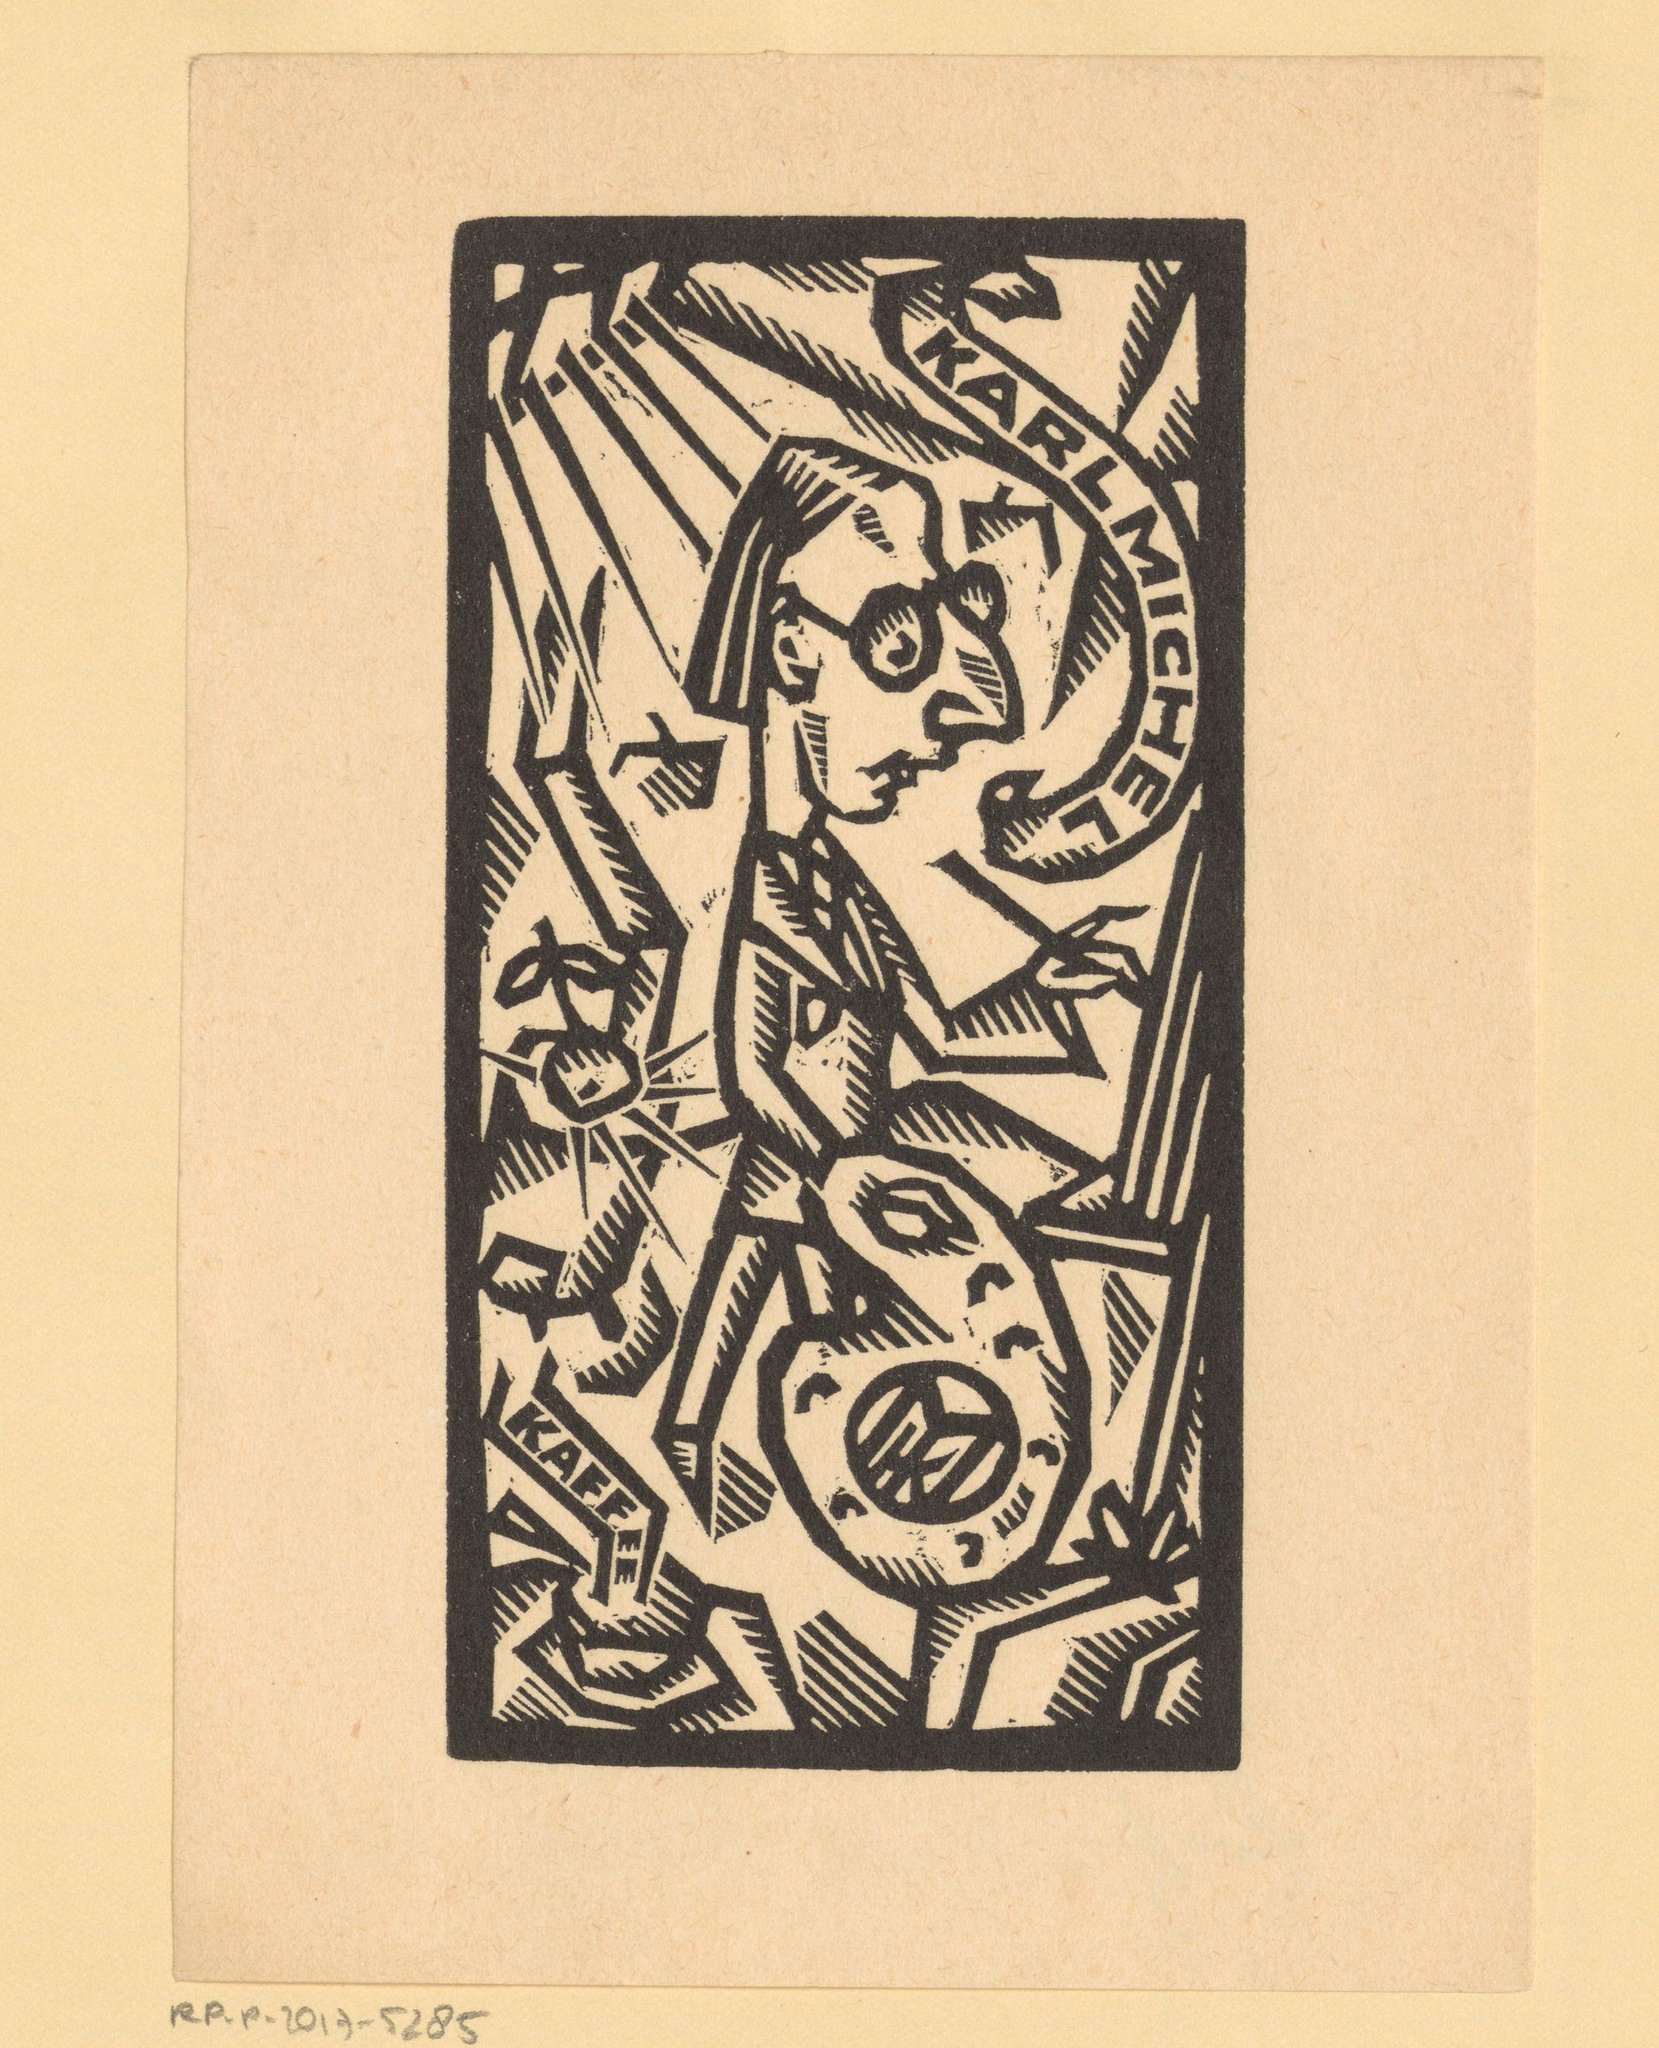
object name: bookplate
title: Ex libris van Karl Michel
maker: Anonymous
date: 1930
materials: paper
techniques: printing block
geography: germany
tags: zwickau, painter, print maker, karl michel, painter at work, in his studio, sun as celestial body, cup of coffee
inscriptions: inscription: ‘Prof Karl Michel Blei’